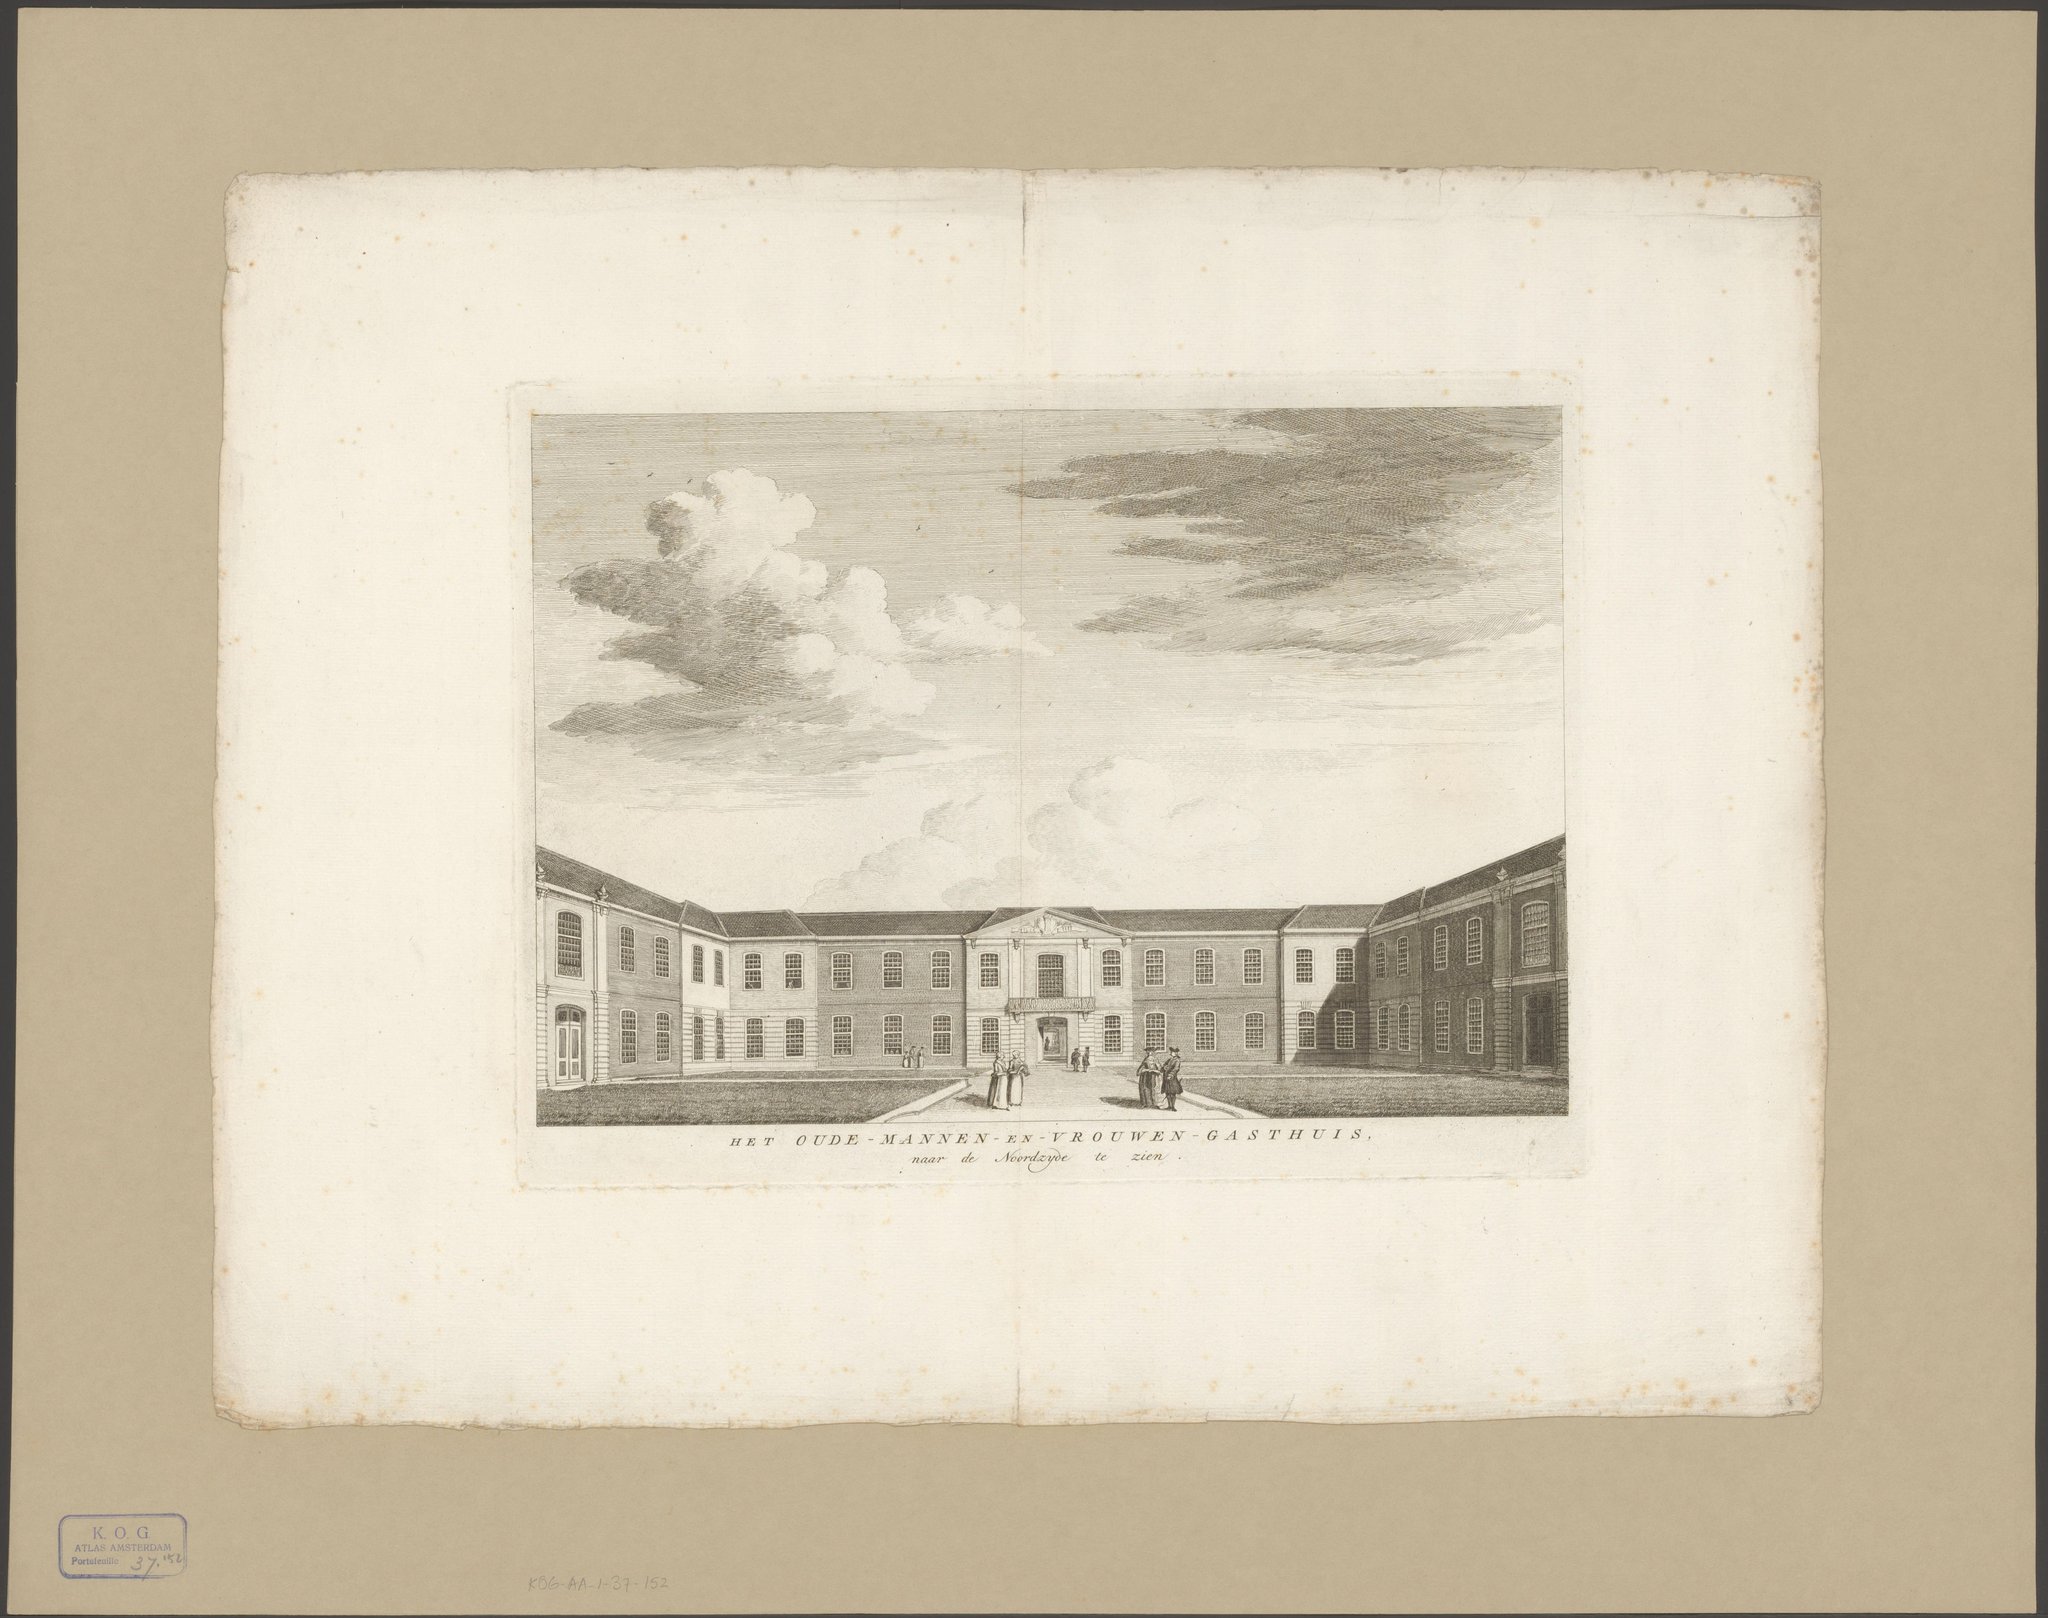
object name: print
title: Gezicht op het Oudemannenhuis te Amsterdam, gezien richting het noorden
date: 1765-1782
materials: paper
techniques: engraving, etching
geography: amsterdam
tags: courtyard, old-people's home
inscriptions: collector's mark: Lugt 1641b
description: Prent mogelijk uit: Wagenaar, Jan. Amsterdam, in zyne opkomst, aanwas, geschiedenissen (…). Amsterdam: Isaak Tirion, 1765, dl. 2. Of uit: Verzameling der fraaiste gezigten van Amsterdam in negen en zeventig afbeeldingen. Amsterdam en Harlingen: Petrus Conradi en Volkert van der Plaats, 1782.